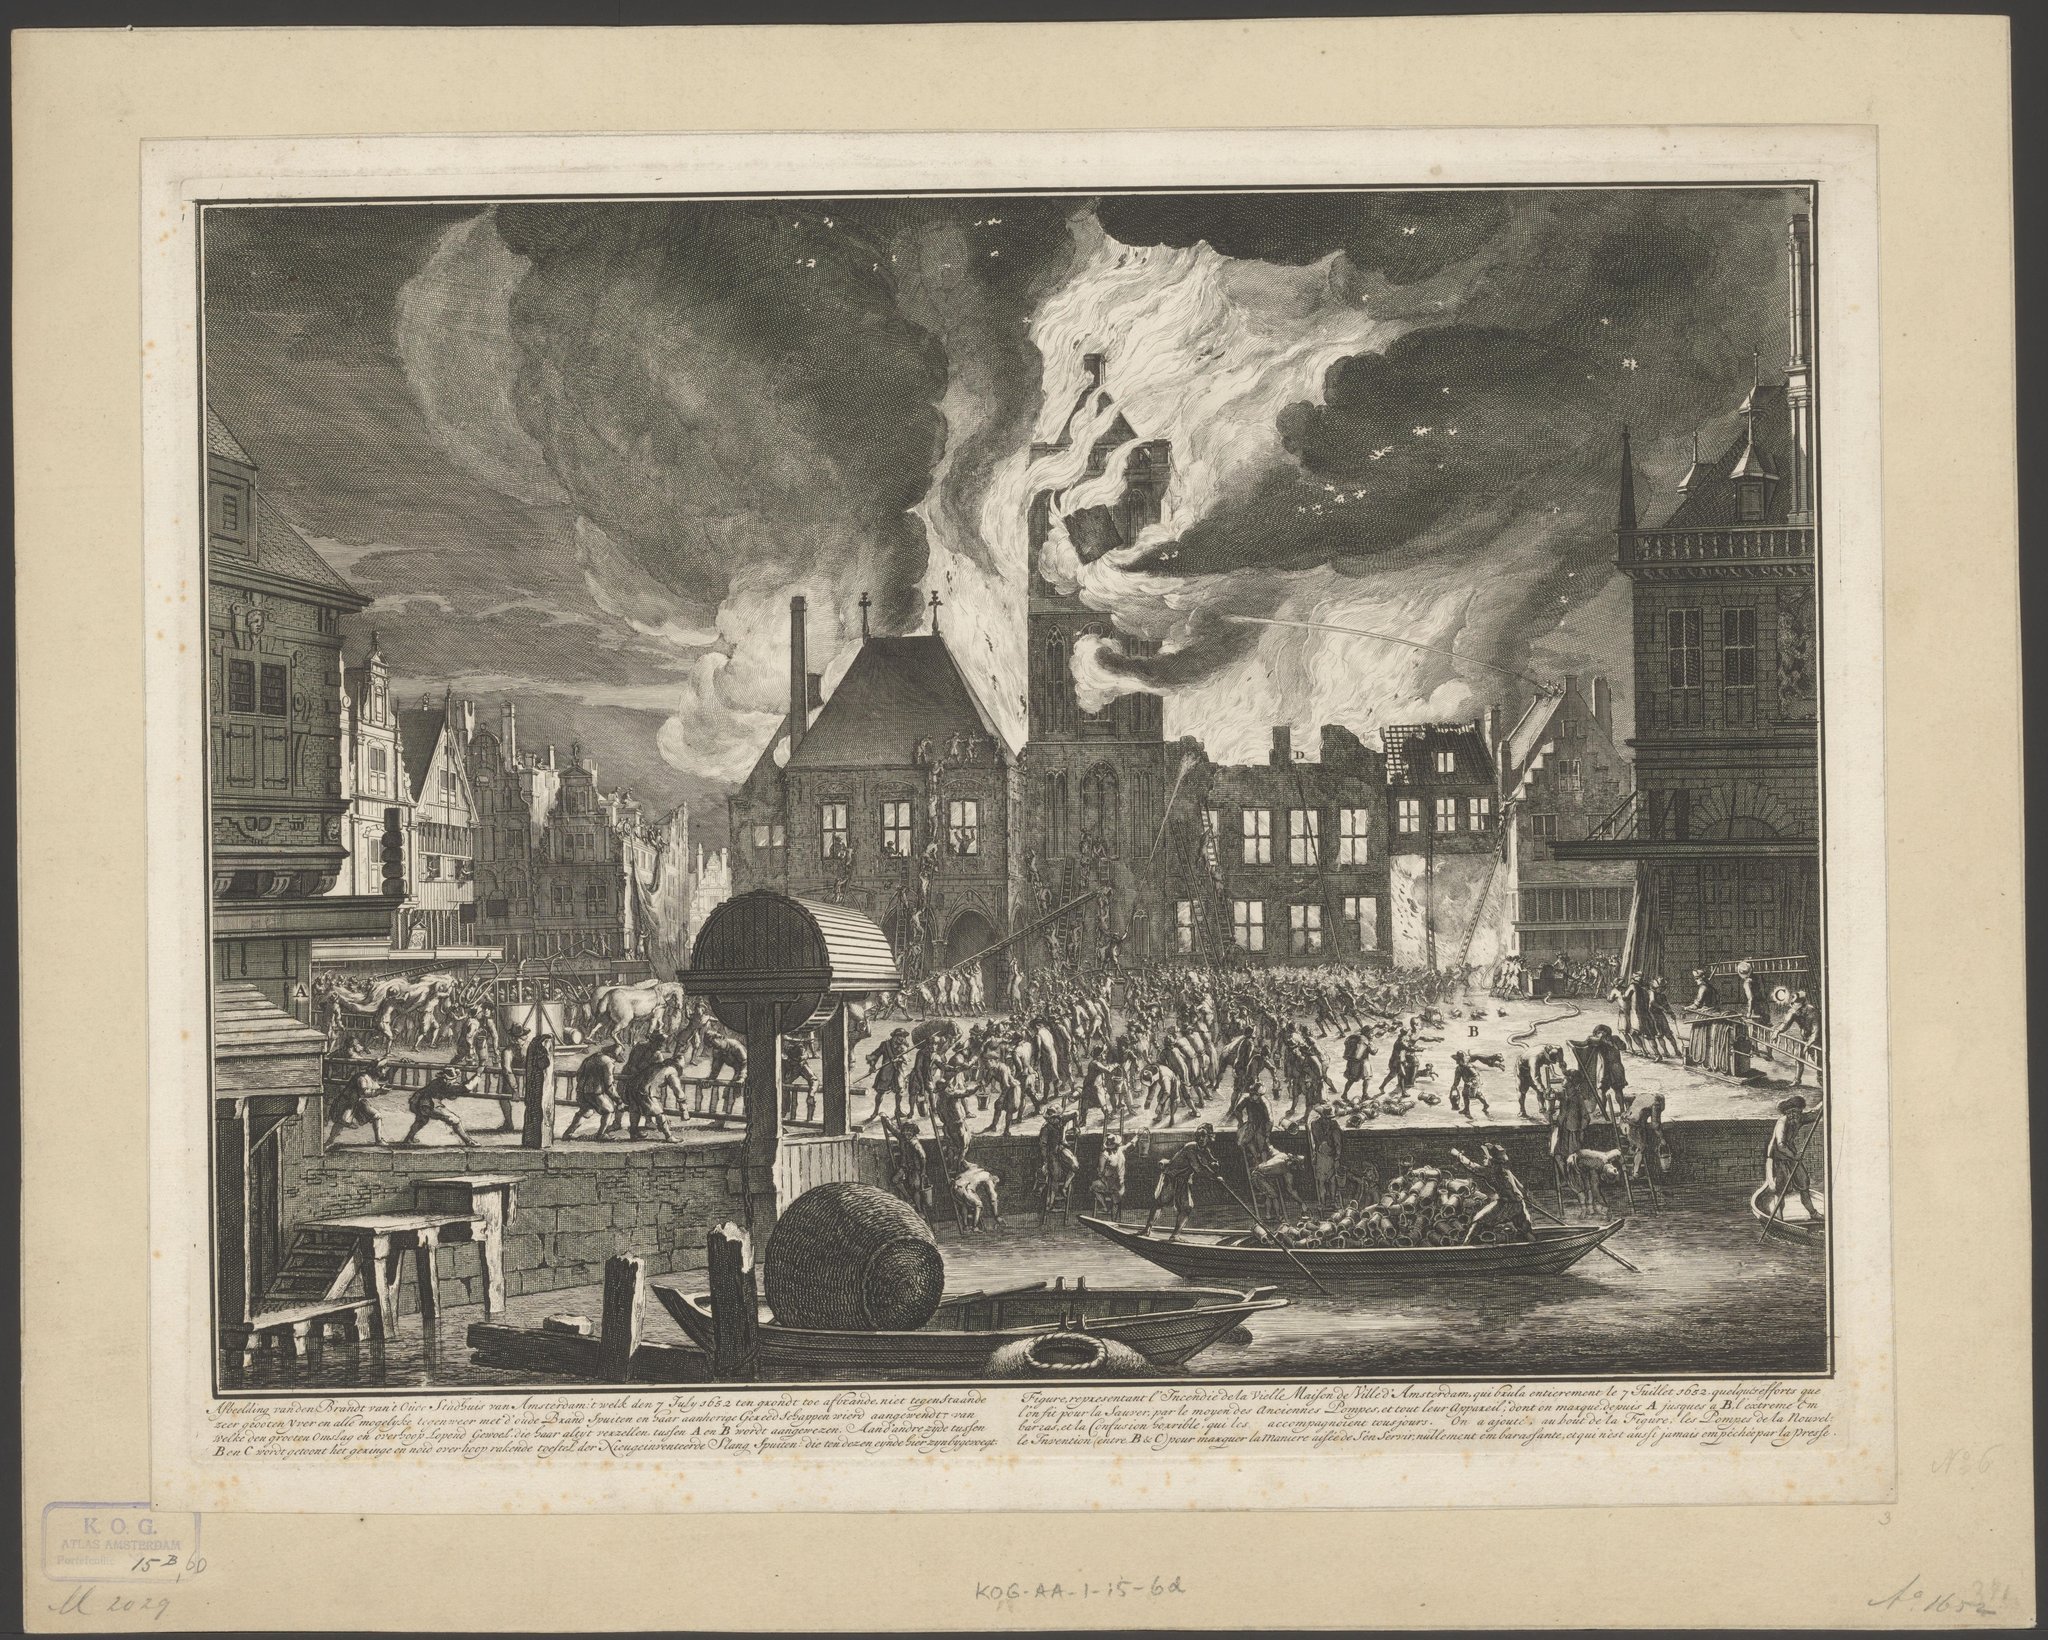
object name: print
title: Gezicht op de brand van in het oude stadhuis van Amsterdam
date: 1690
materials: paper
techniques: engraving, etching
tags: on fire, ablaze, city-view in general; 'veduta', townhall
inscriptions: collector's mark: ‘15B, 6D’ Lugt 1641b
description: Huidige staat van prent ook gebruikt in: Heyden, Jan van der. Beschryving der nieuwlyks uitgevonden en geoctrojeerde slang-brand-spuiten en haare wyze van brand-blussen, tegenwoordig binnen Amsterdam in gebruik zijnde (…). 1e druk. Amsterdam: Jan Rieuwertsz. (II), 1690. Derde bekende staat van prent ook gebruikt in: Heyden, Jan van der. Beschryving der nieuwlyks uitgevonden en geoctrojeerde slang-brand-spuiten en haare wyze van brand-blussen, tegenwoordig binnen Amsterdam in gebruik zijnde (…). 2e druk. Amsterdam: erfgenamen Jan van der Heyden, 1735. Voor eerste bekende staat zie RP-P-AO-28-44-2 en RP-P-OB-55.389. Voor tweede bekende staat zie RP-P-OB-81.741 en RP-P-OB-82.081. Voor derde bekende staat zie RP-P-AO-28-44-1 en RP-P-OB-81.742.